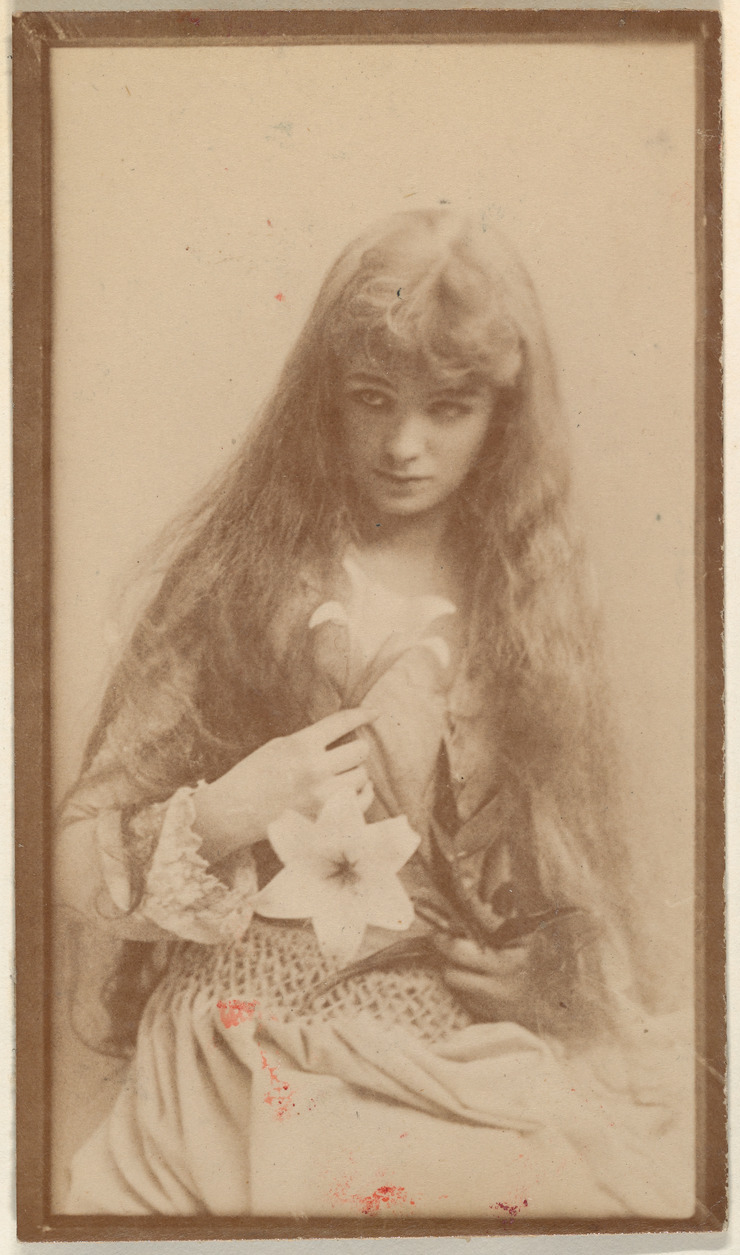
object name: photograph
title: Actress with long hair seated with flower on lap, from the Actresses series (N668)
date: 1888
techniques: albumen silver print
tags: portraits,women,actresses